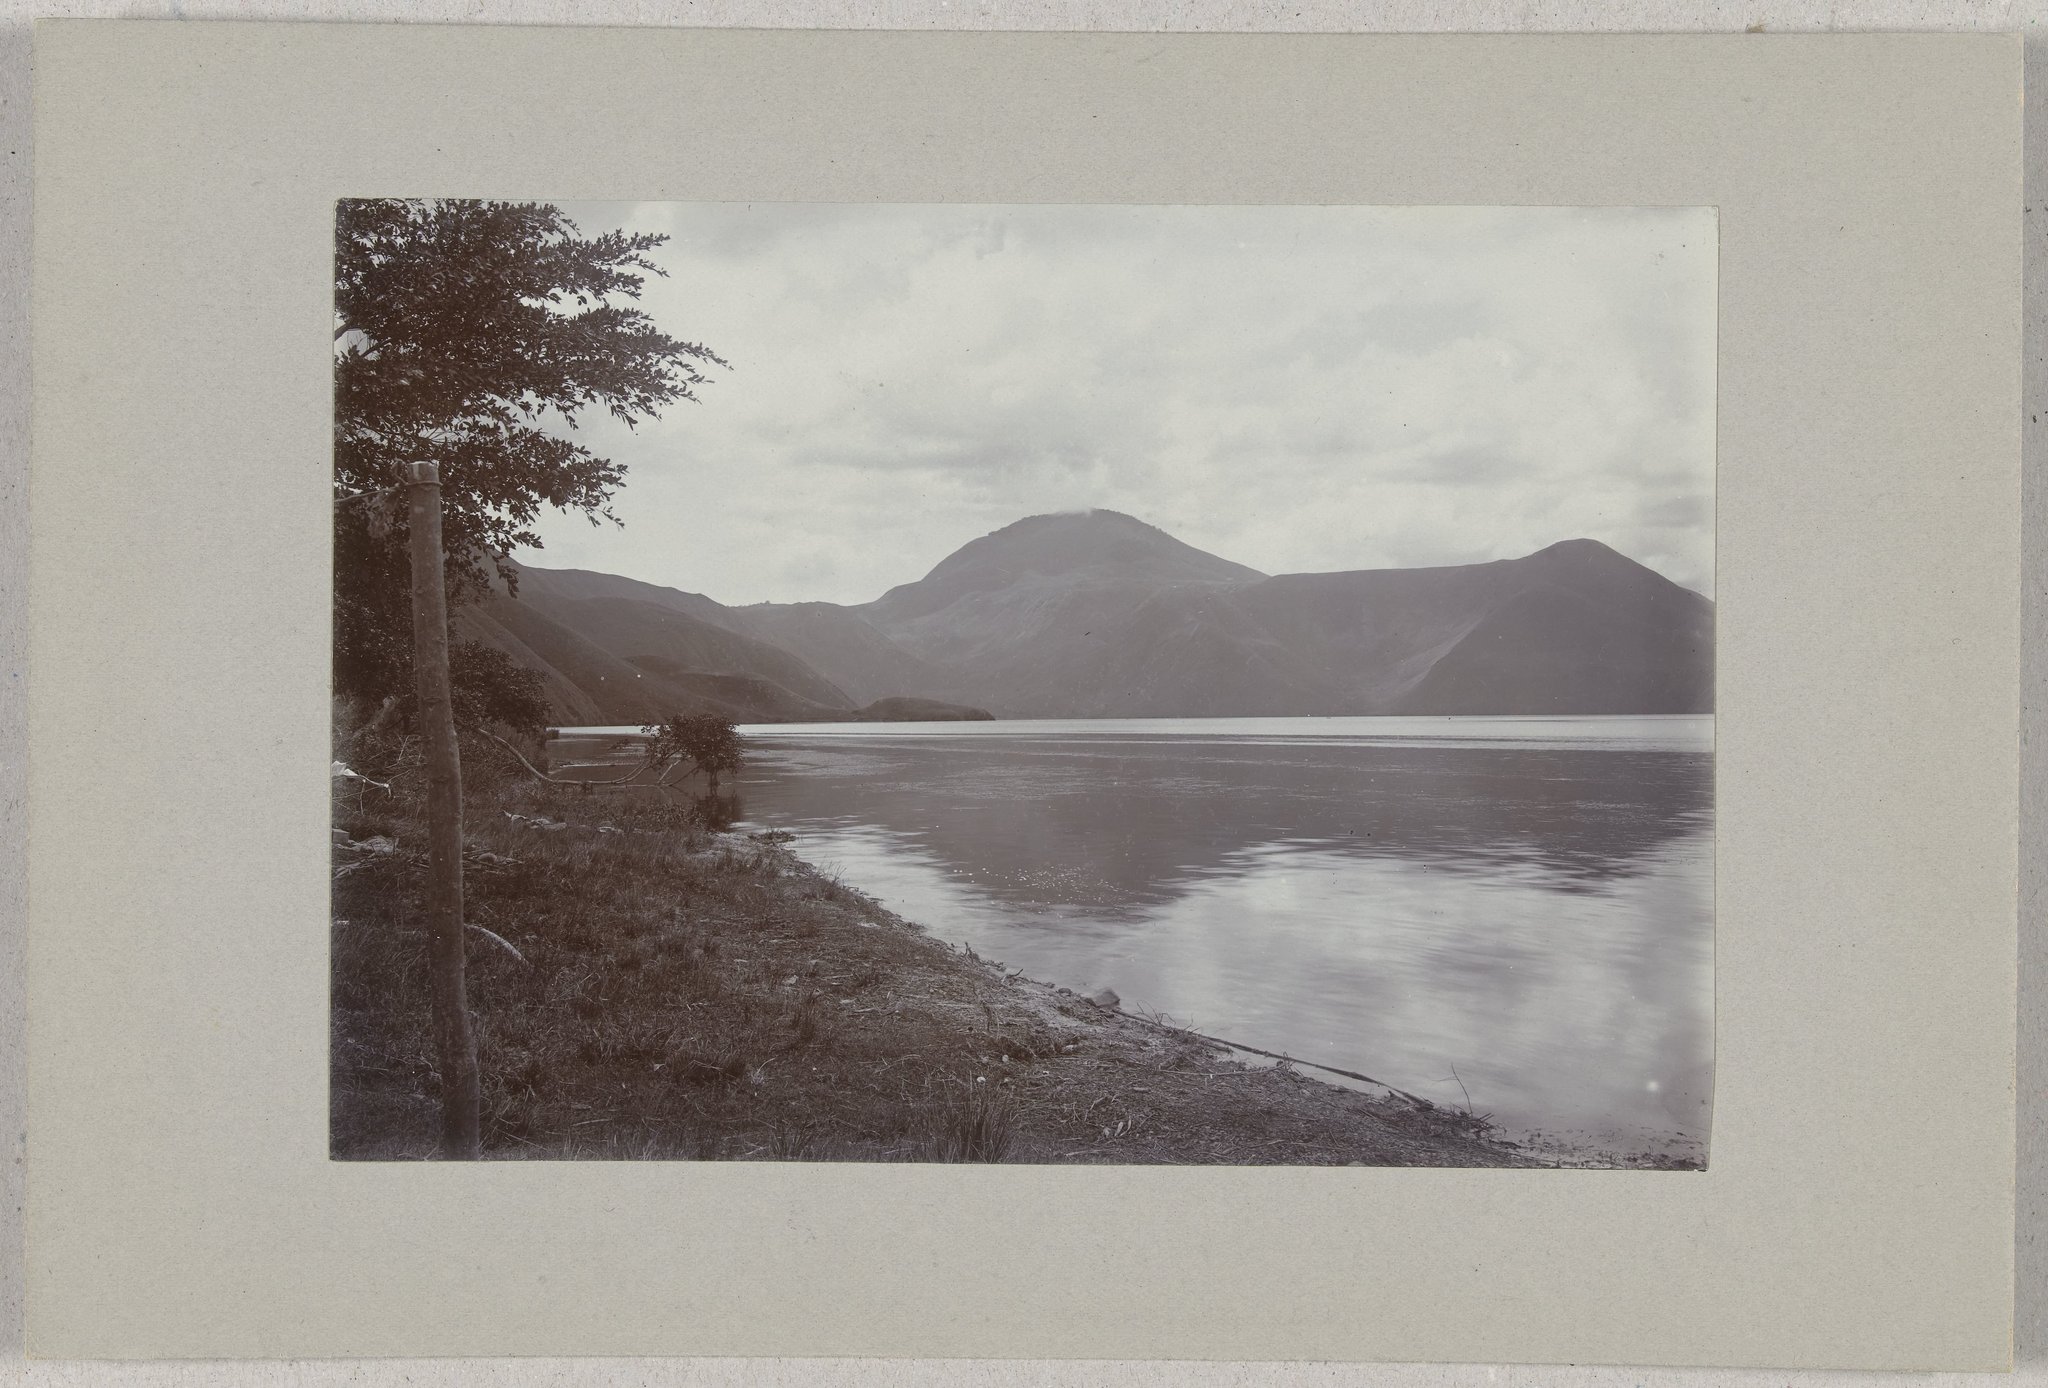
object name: photograph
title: 9b Toba-meer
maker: Anonymous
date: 1895-1915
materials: cardboard, paper, photographic support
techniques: gelatin silver print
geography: sumatra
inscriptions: annotation: ‘9b Toba-meer’